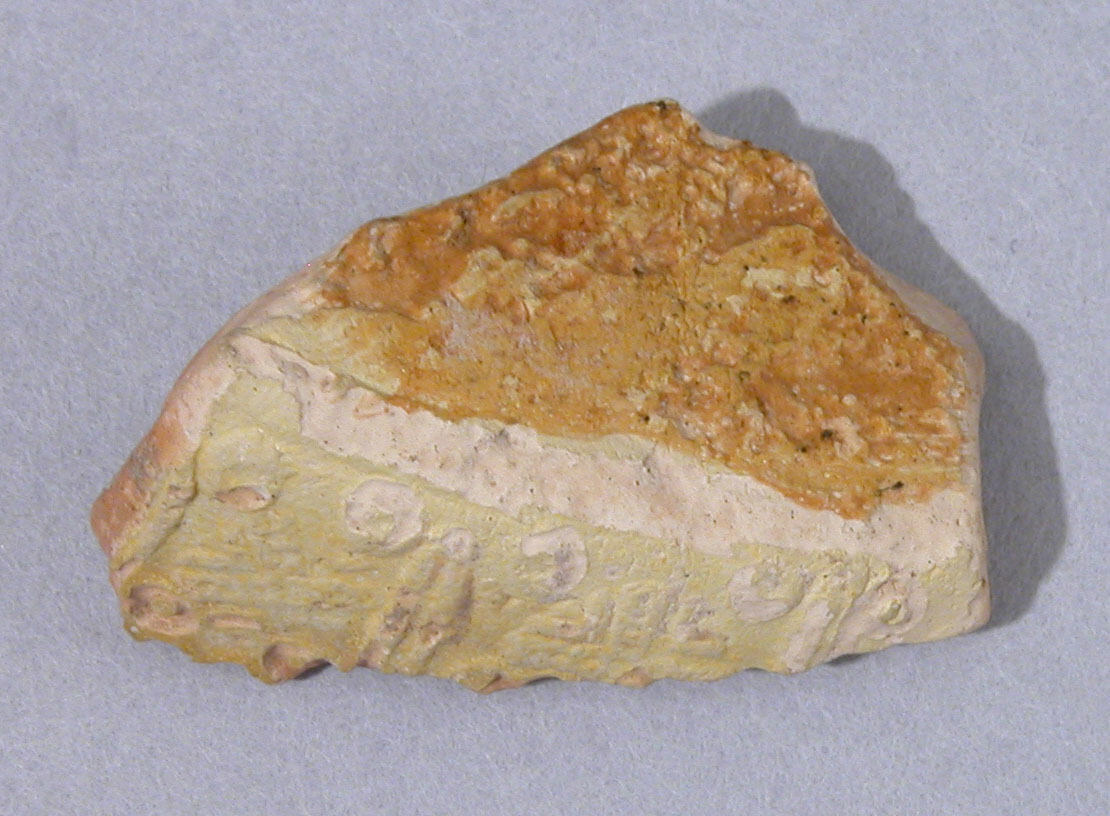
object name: fragment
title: Ceramic Fragment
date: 801-900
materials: earthenware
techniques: glazing, molding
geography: saudi arabia